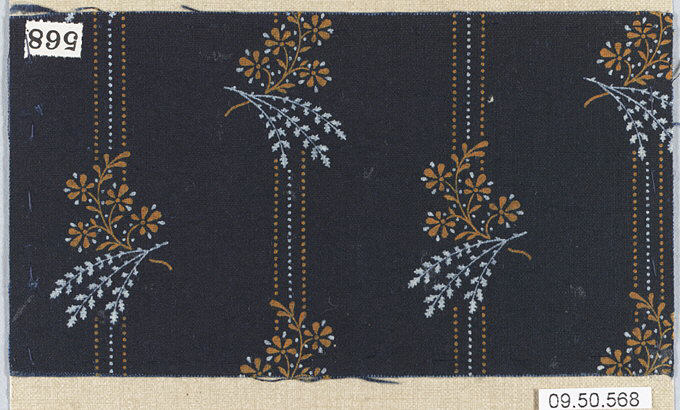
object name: piece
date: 1801-1900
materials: cotton